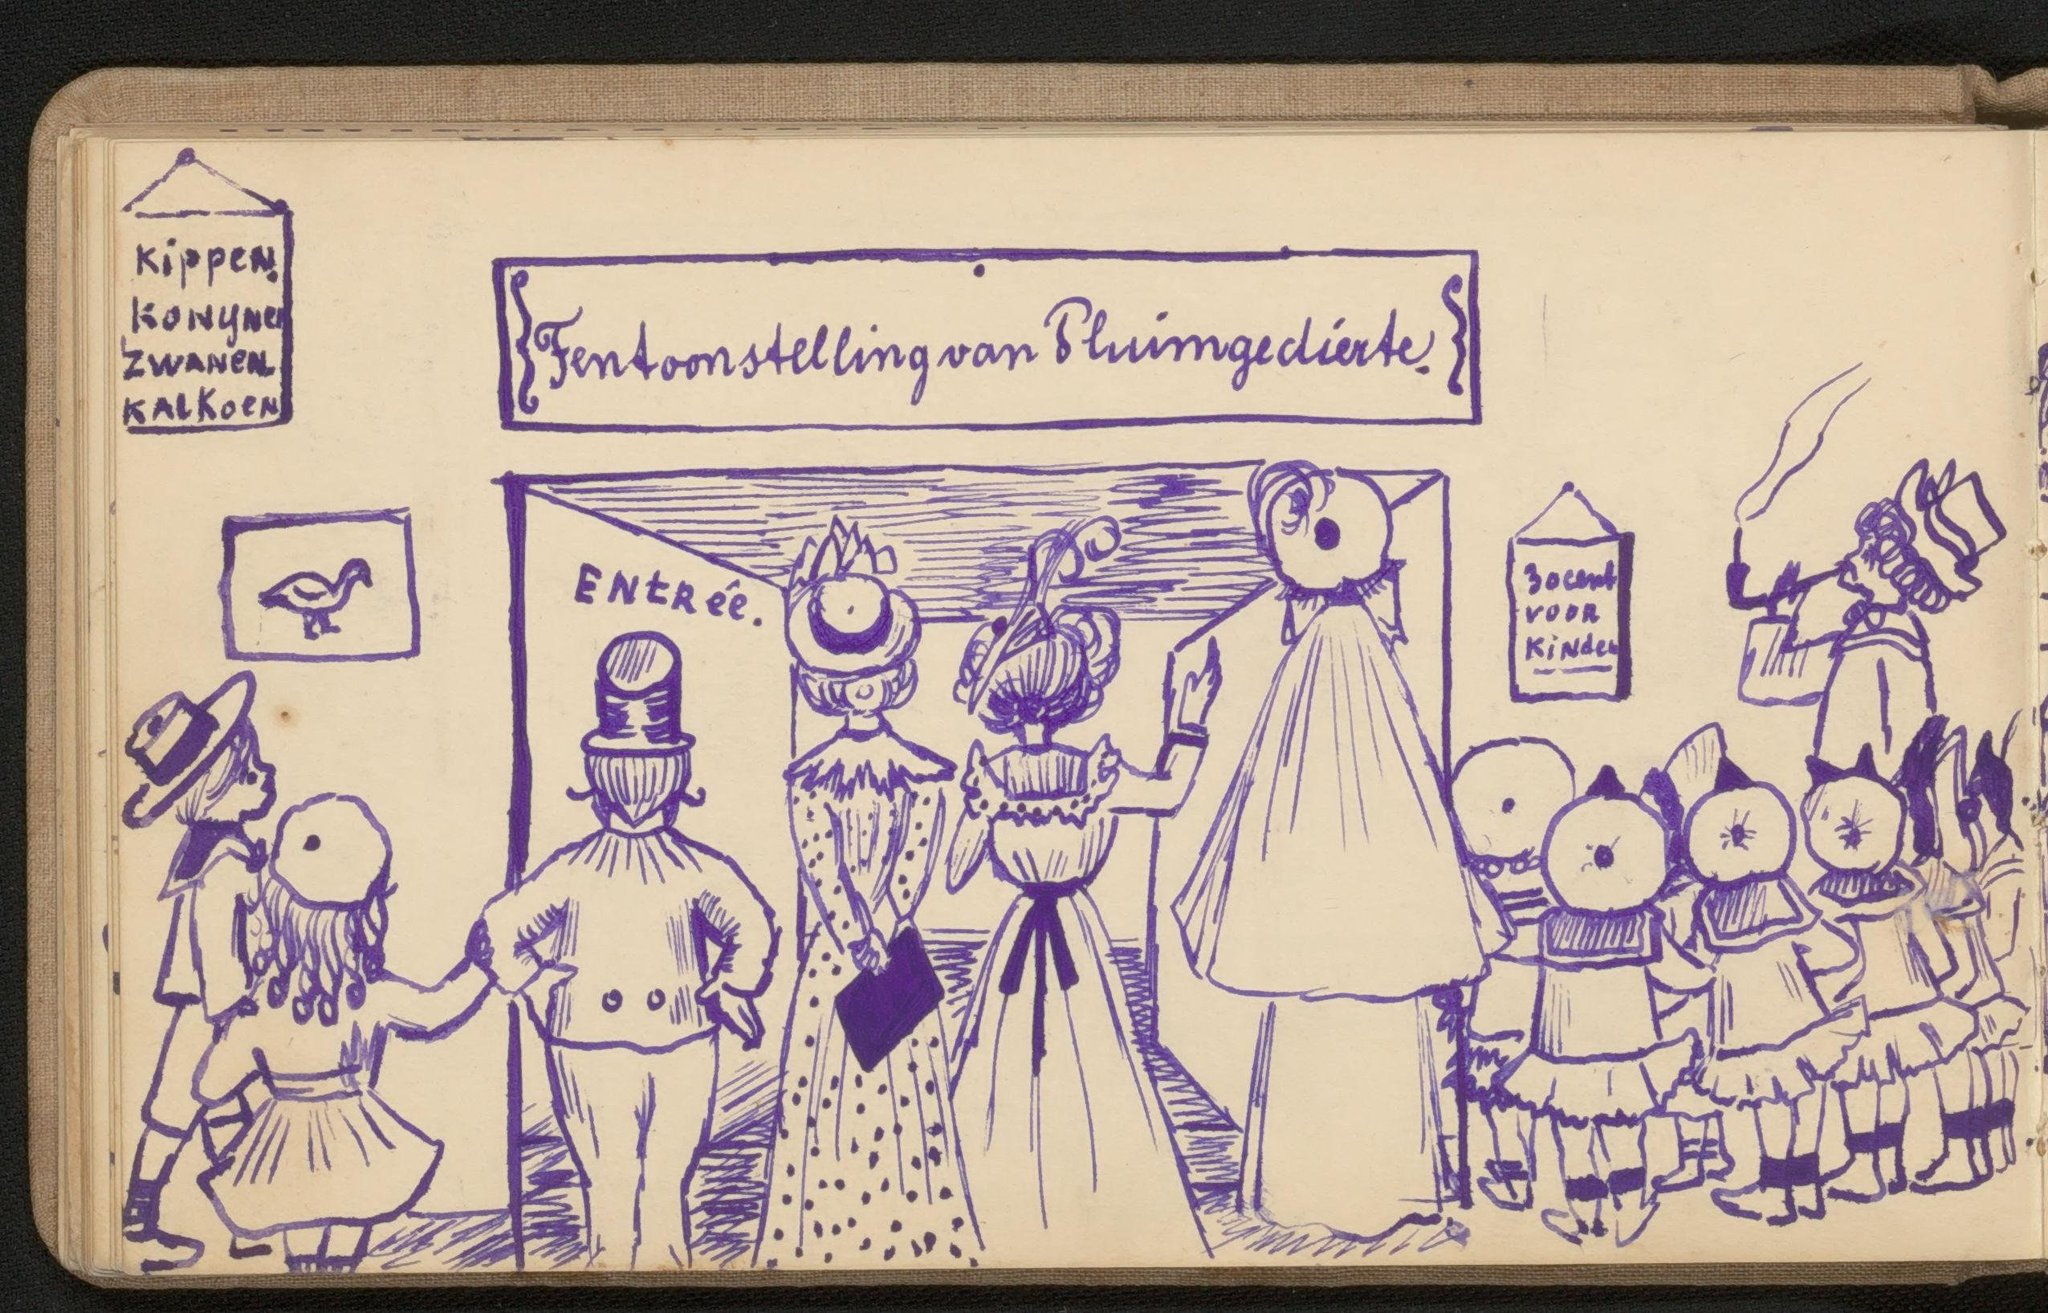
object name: sketchbook leaf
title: Naar het pluimgedierte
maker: Anonymous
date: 1875-1920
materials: ink, paper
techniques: pen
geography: netherlands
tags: fowl (cock, hen, chicken, etc.), collection, exhibition, show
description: De familie brengt een bezoek aan de 'Tentoonstelling van Pluimgedierte'. Onderdeel van het schetsboek met humoristische tekeningen over het leven van een 'famille nombreuse'. Onderwerpsrubrieken binnen de Atlas Zeden en Gewoonten: Zeden en Gewoonten in Engeren Zin, Des menschen beging, midden en einde, Kinderleven.